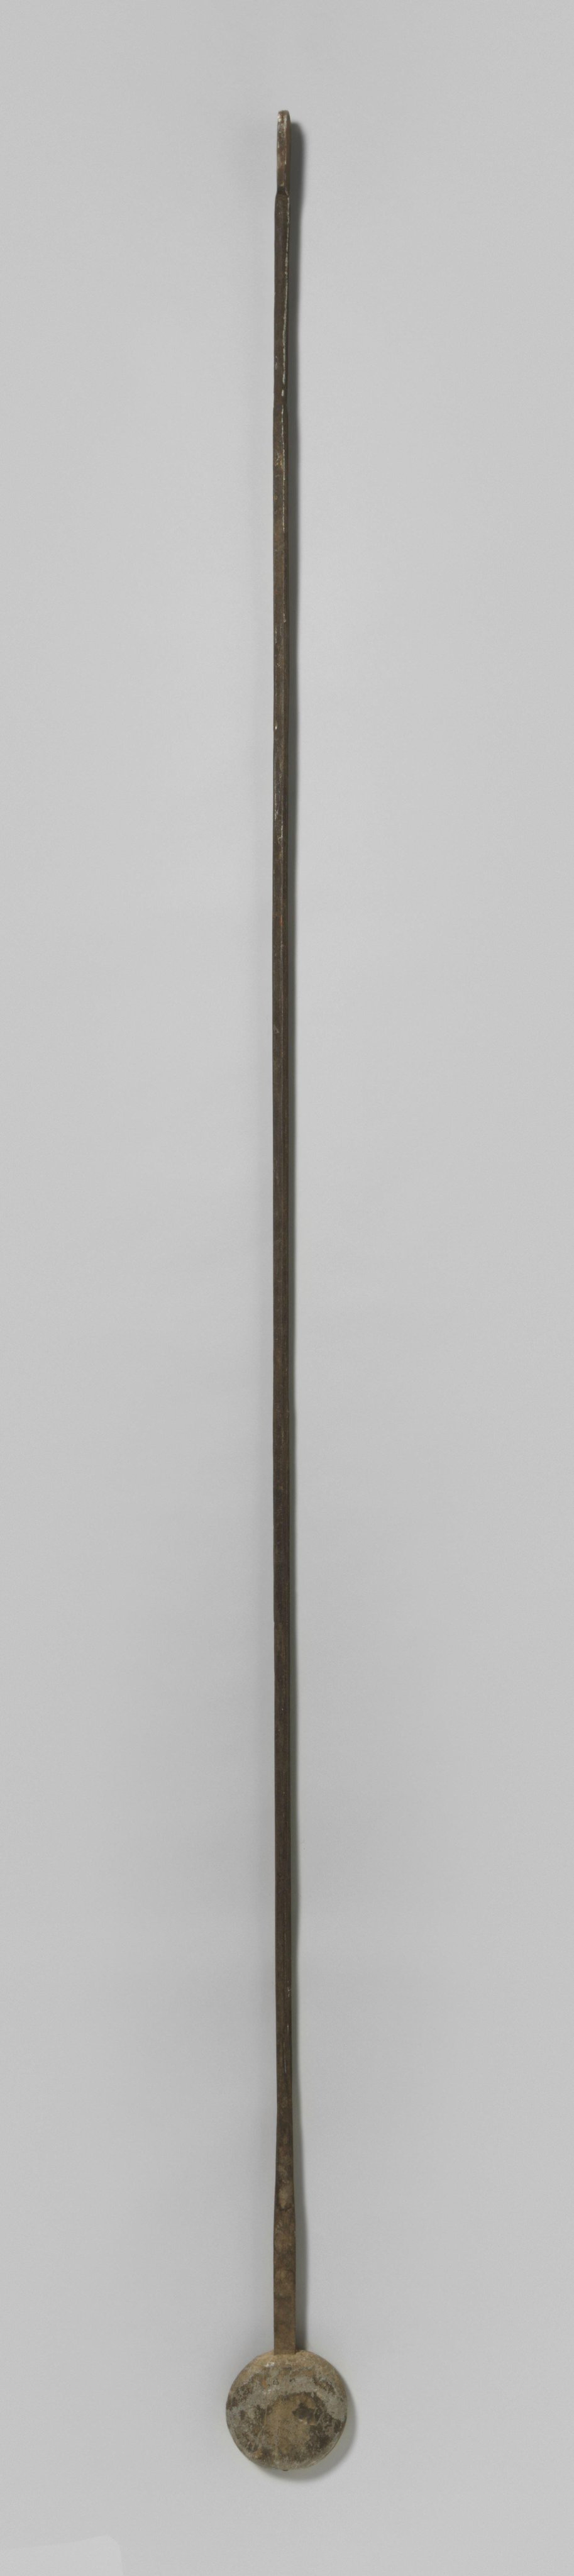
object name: tower clock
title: Slinger van het torenuurwerk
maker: Anonymous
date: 1585-1615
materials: iron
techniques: forging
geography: northern netherlands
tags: waterpoort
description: Slinger van het torenuurwerk afkomstig van de afgebroken Waterpoort te Gorinchem